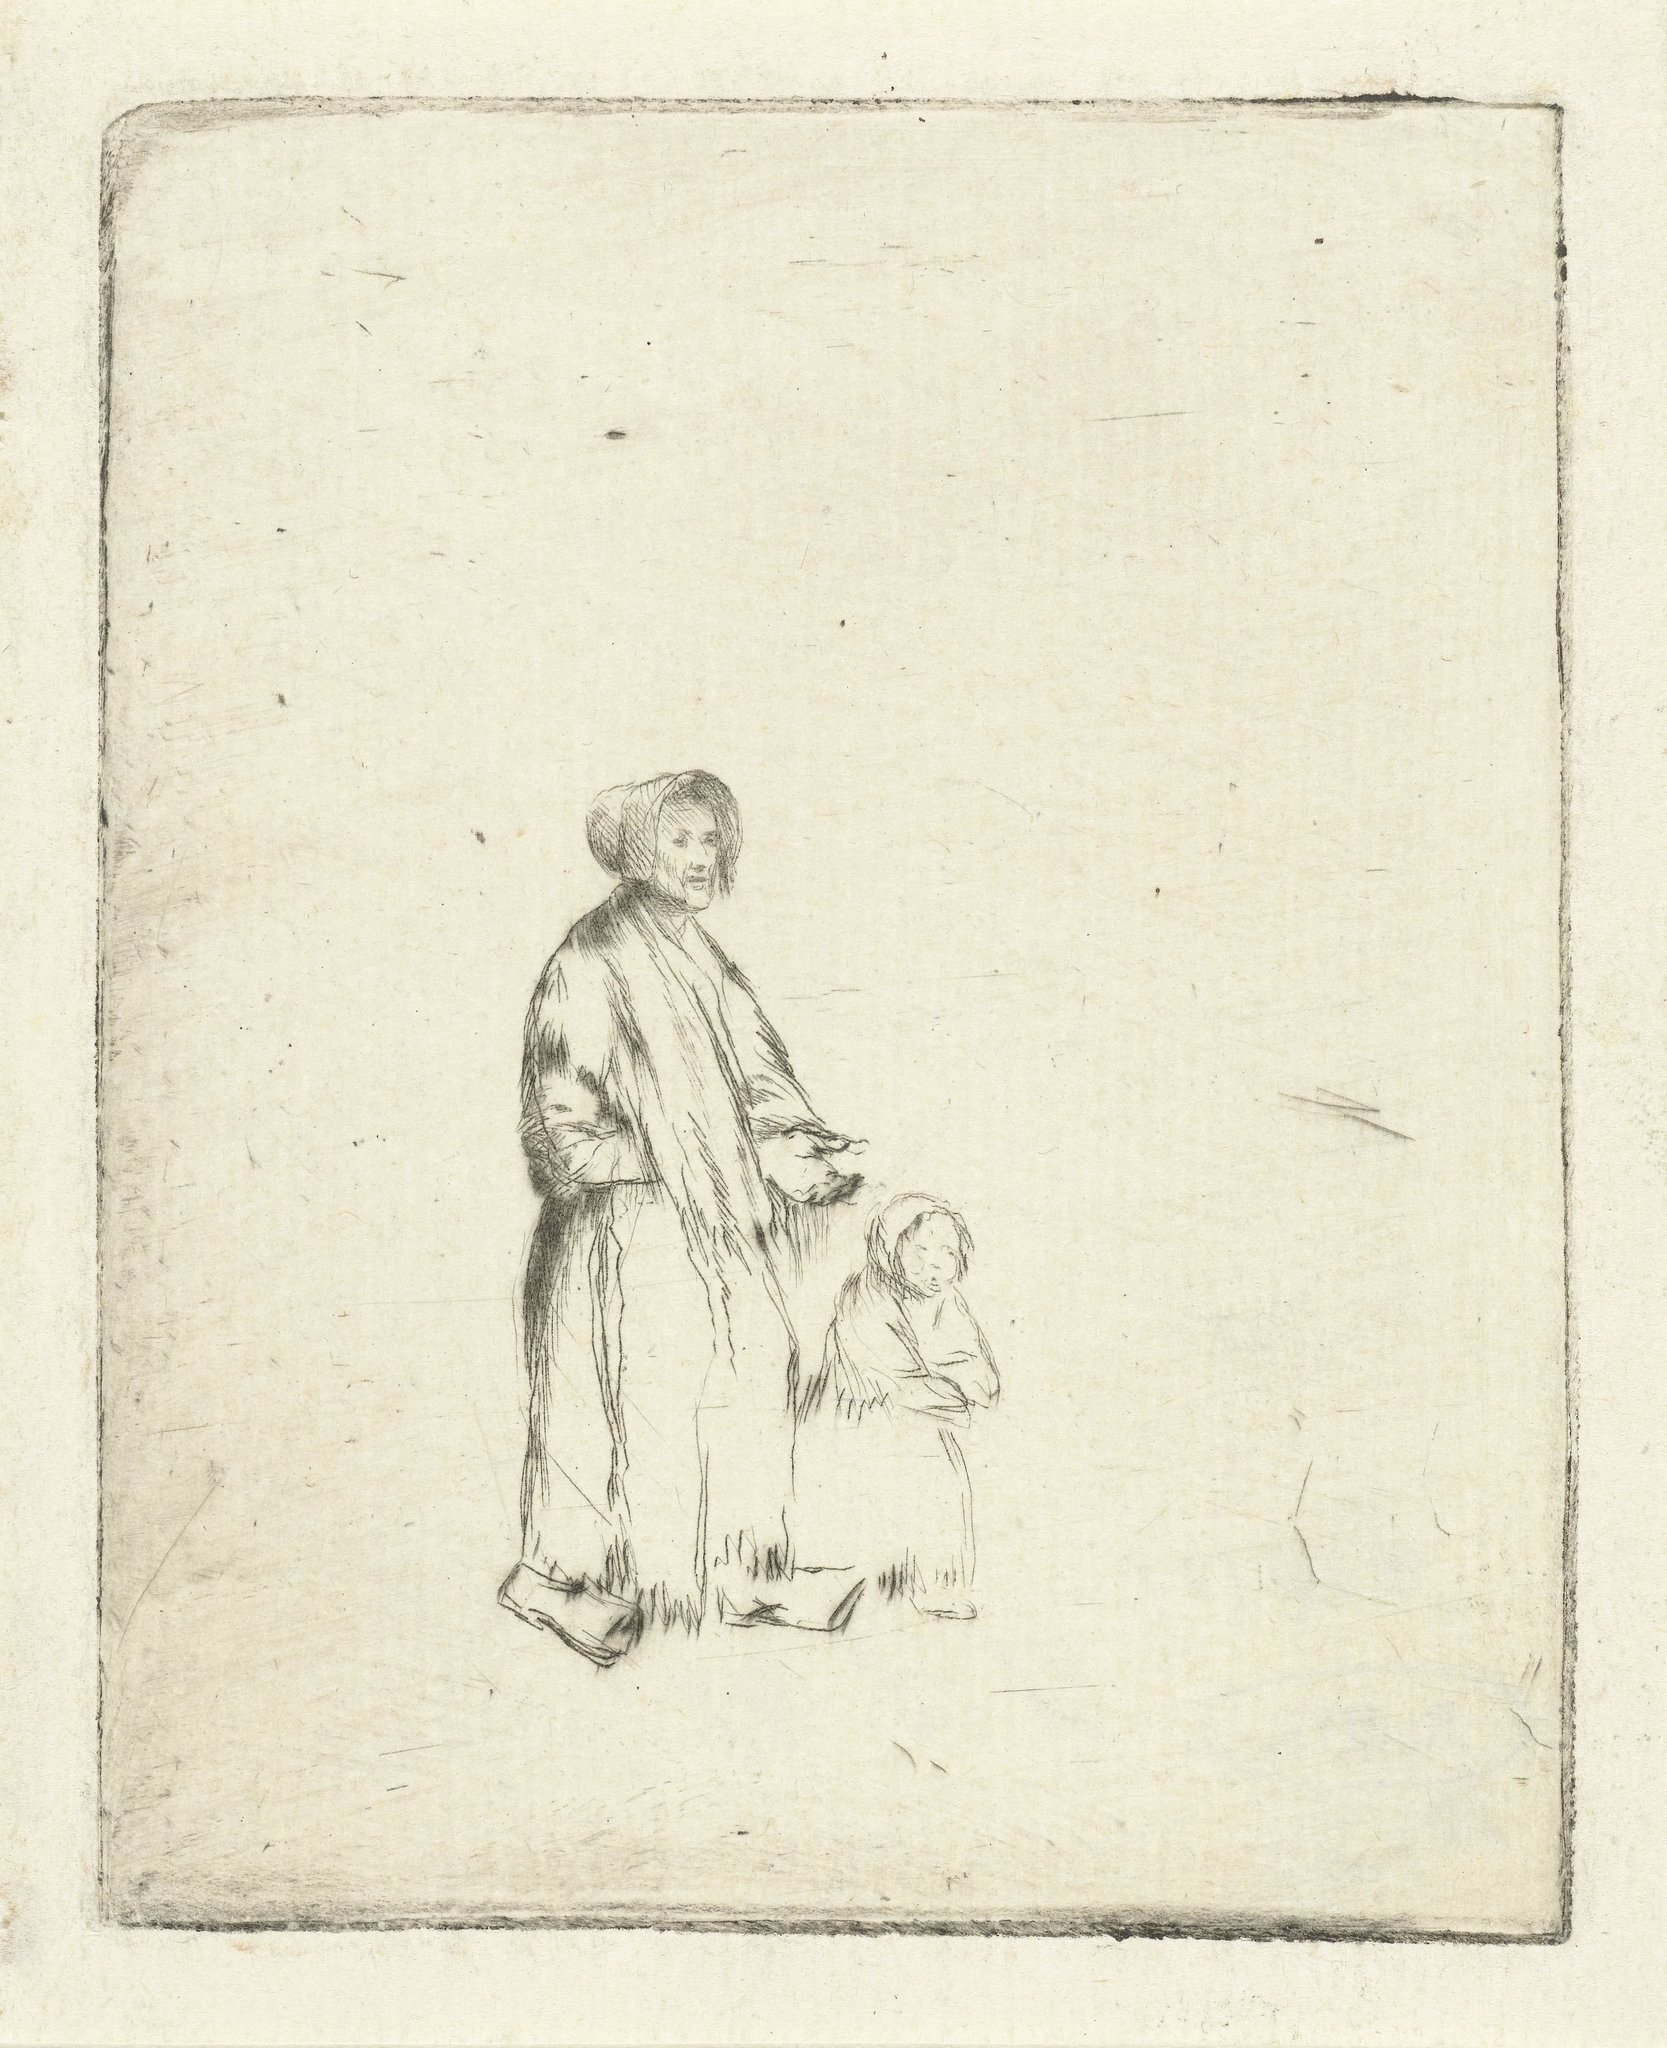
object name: print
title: Bedelaarster met kind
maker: louis bernard coclers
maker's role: draughtsman, print maker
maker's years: 1741-1817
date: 1756-1817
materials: paper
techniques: drypoint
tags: beggar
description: Een bedelaarster met een klein meisje. Ze houdt haar hand open om naar een aalmoes te vragen.